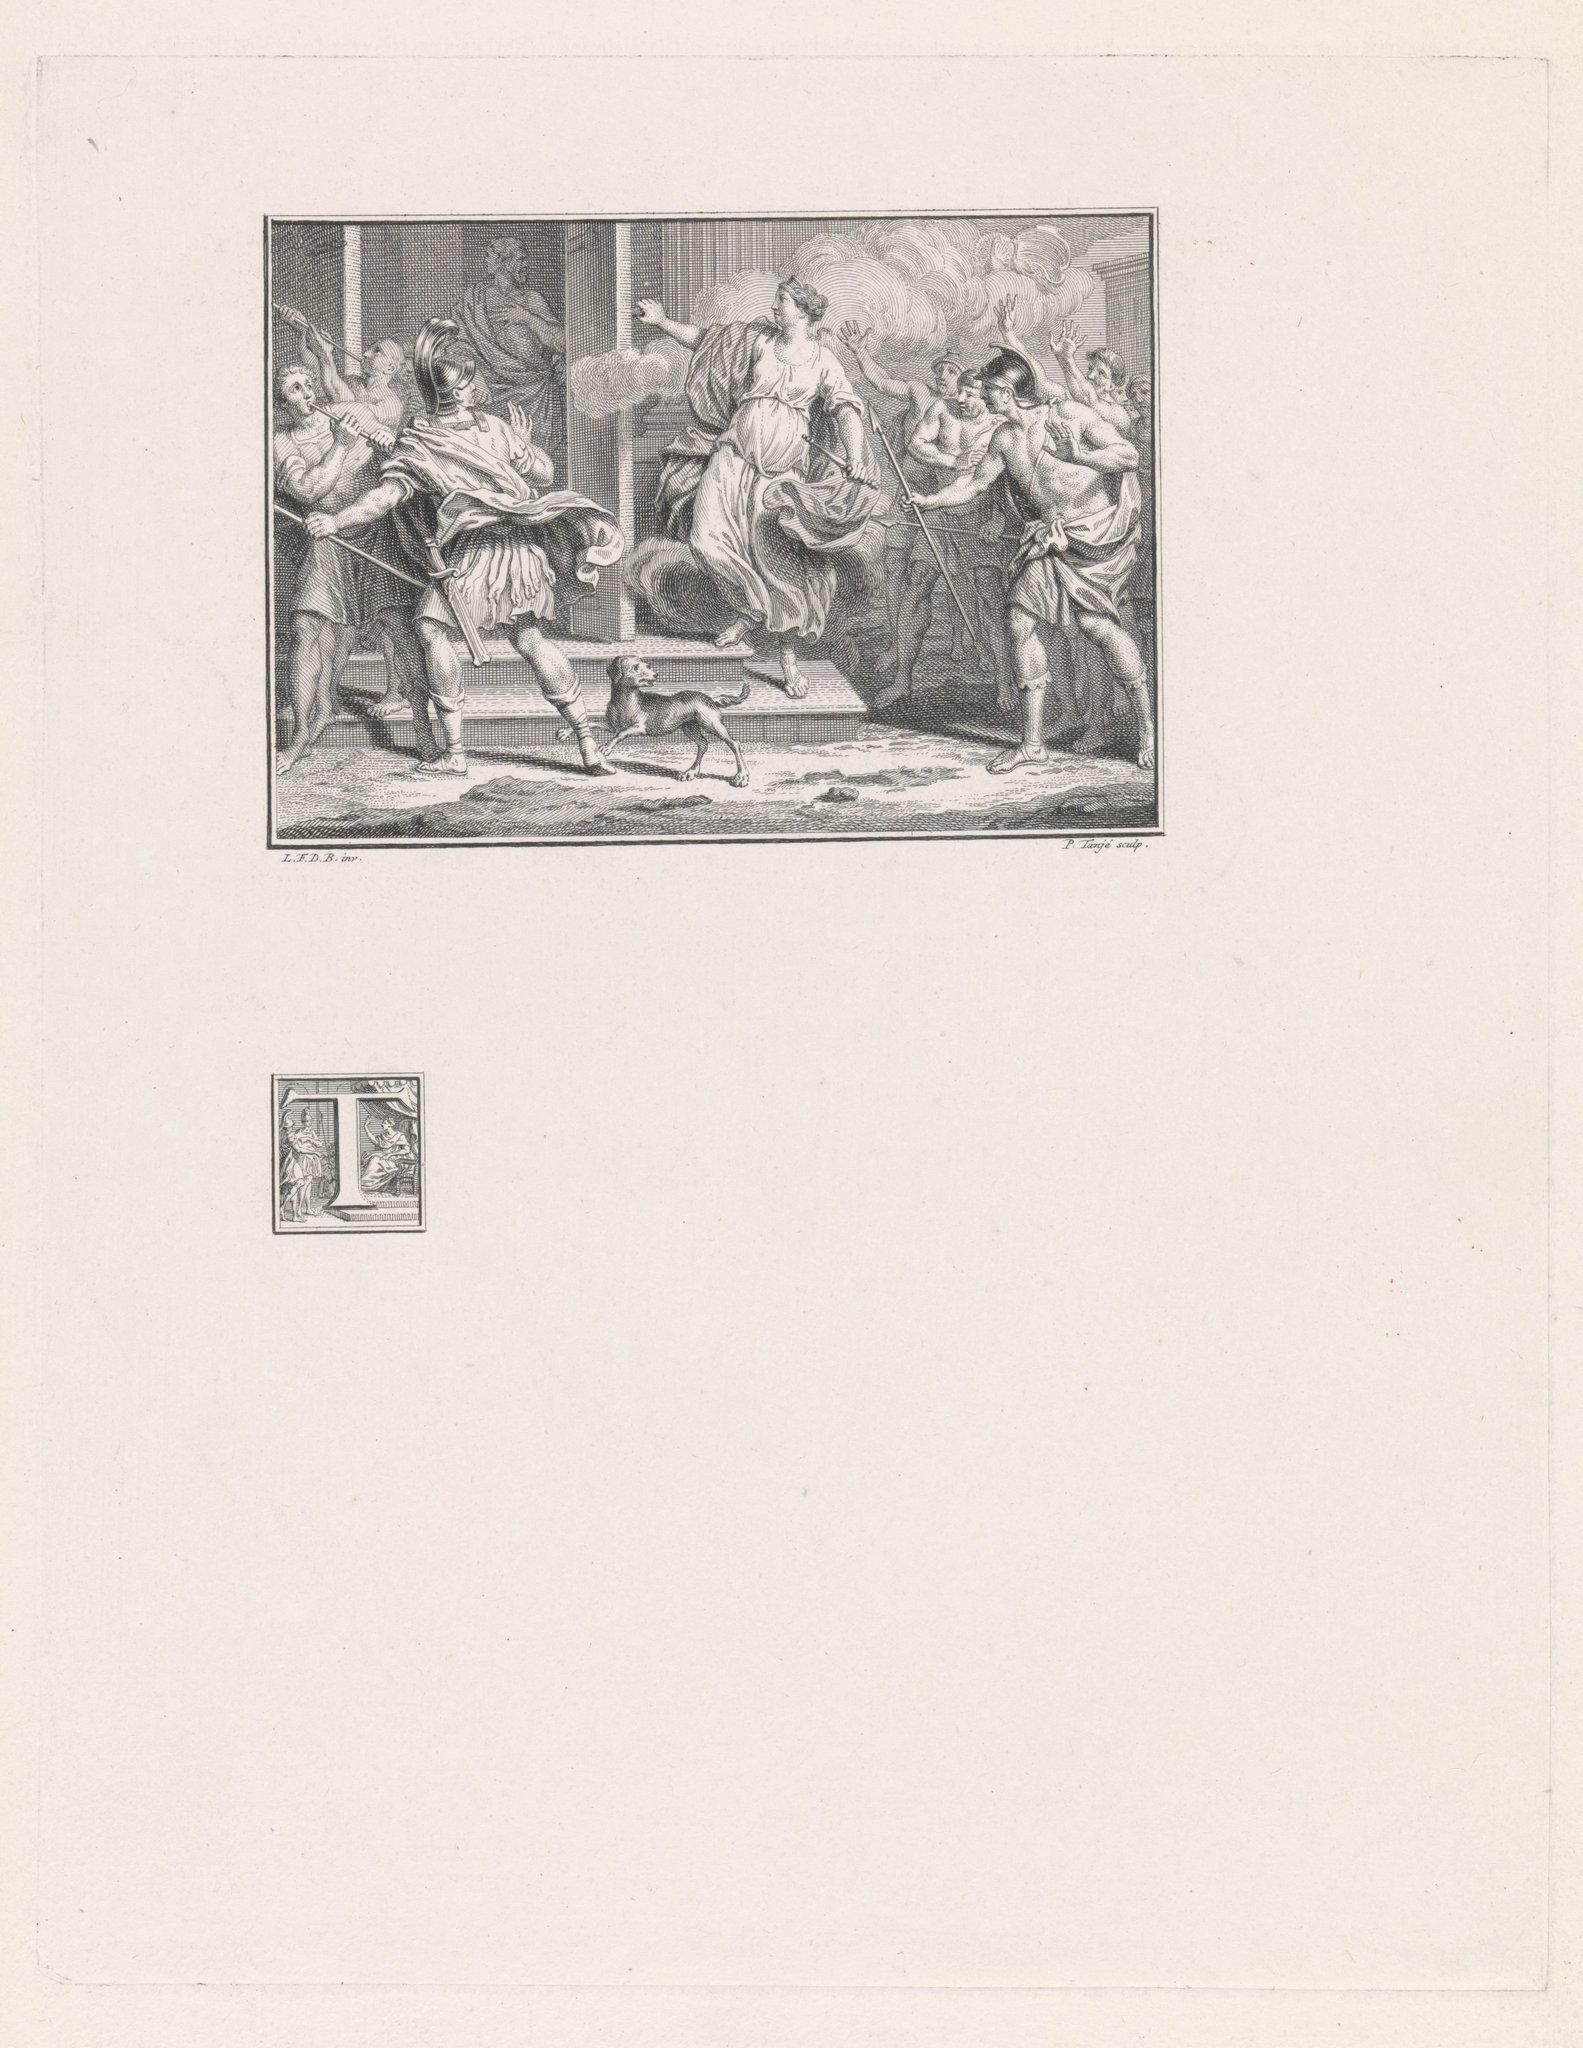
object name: book illustration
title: Scène uit de Aeneis: Aeneas en een vrouw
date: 1746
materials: paper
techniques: engraving, etching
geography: amsterdam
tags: the story of aeneas' wanderings to italy (virgil, aeneid)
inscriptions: collector's mark: Lugt 240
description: Aeneas vlucht weg van een vrouw met een scepter. Achter haar een rookpluim en links een beeld in een tempel. Illustratie en initiaal T bij een van de delen van de Aeneis van Vergilius.